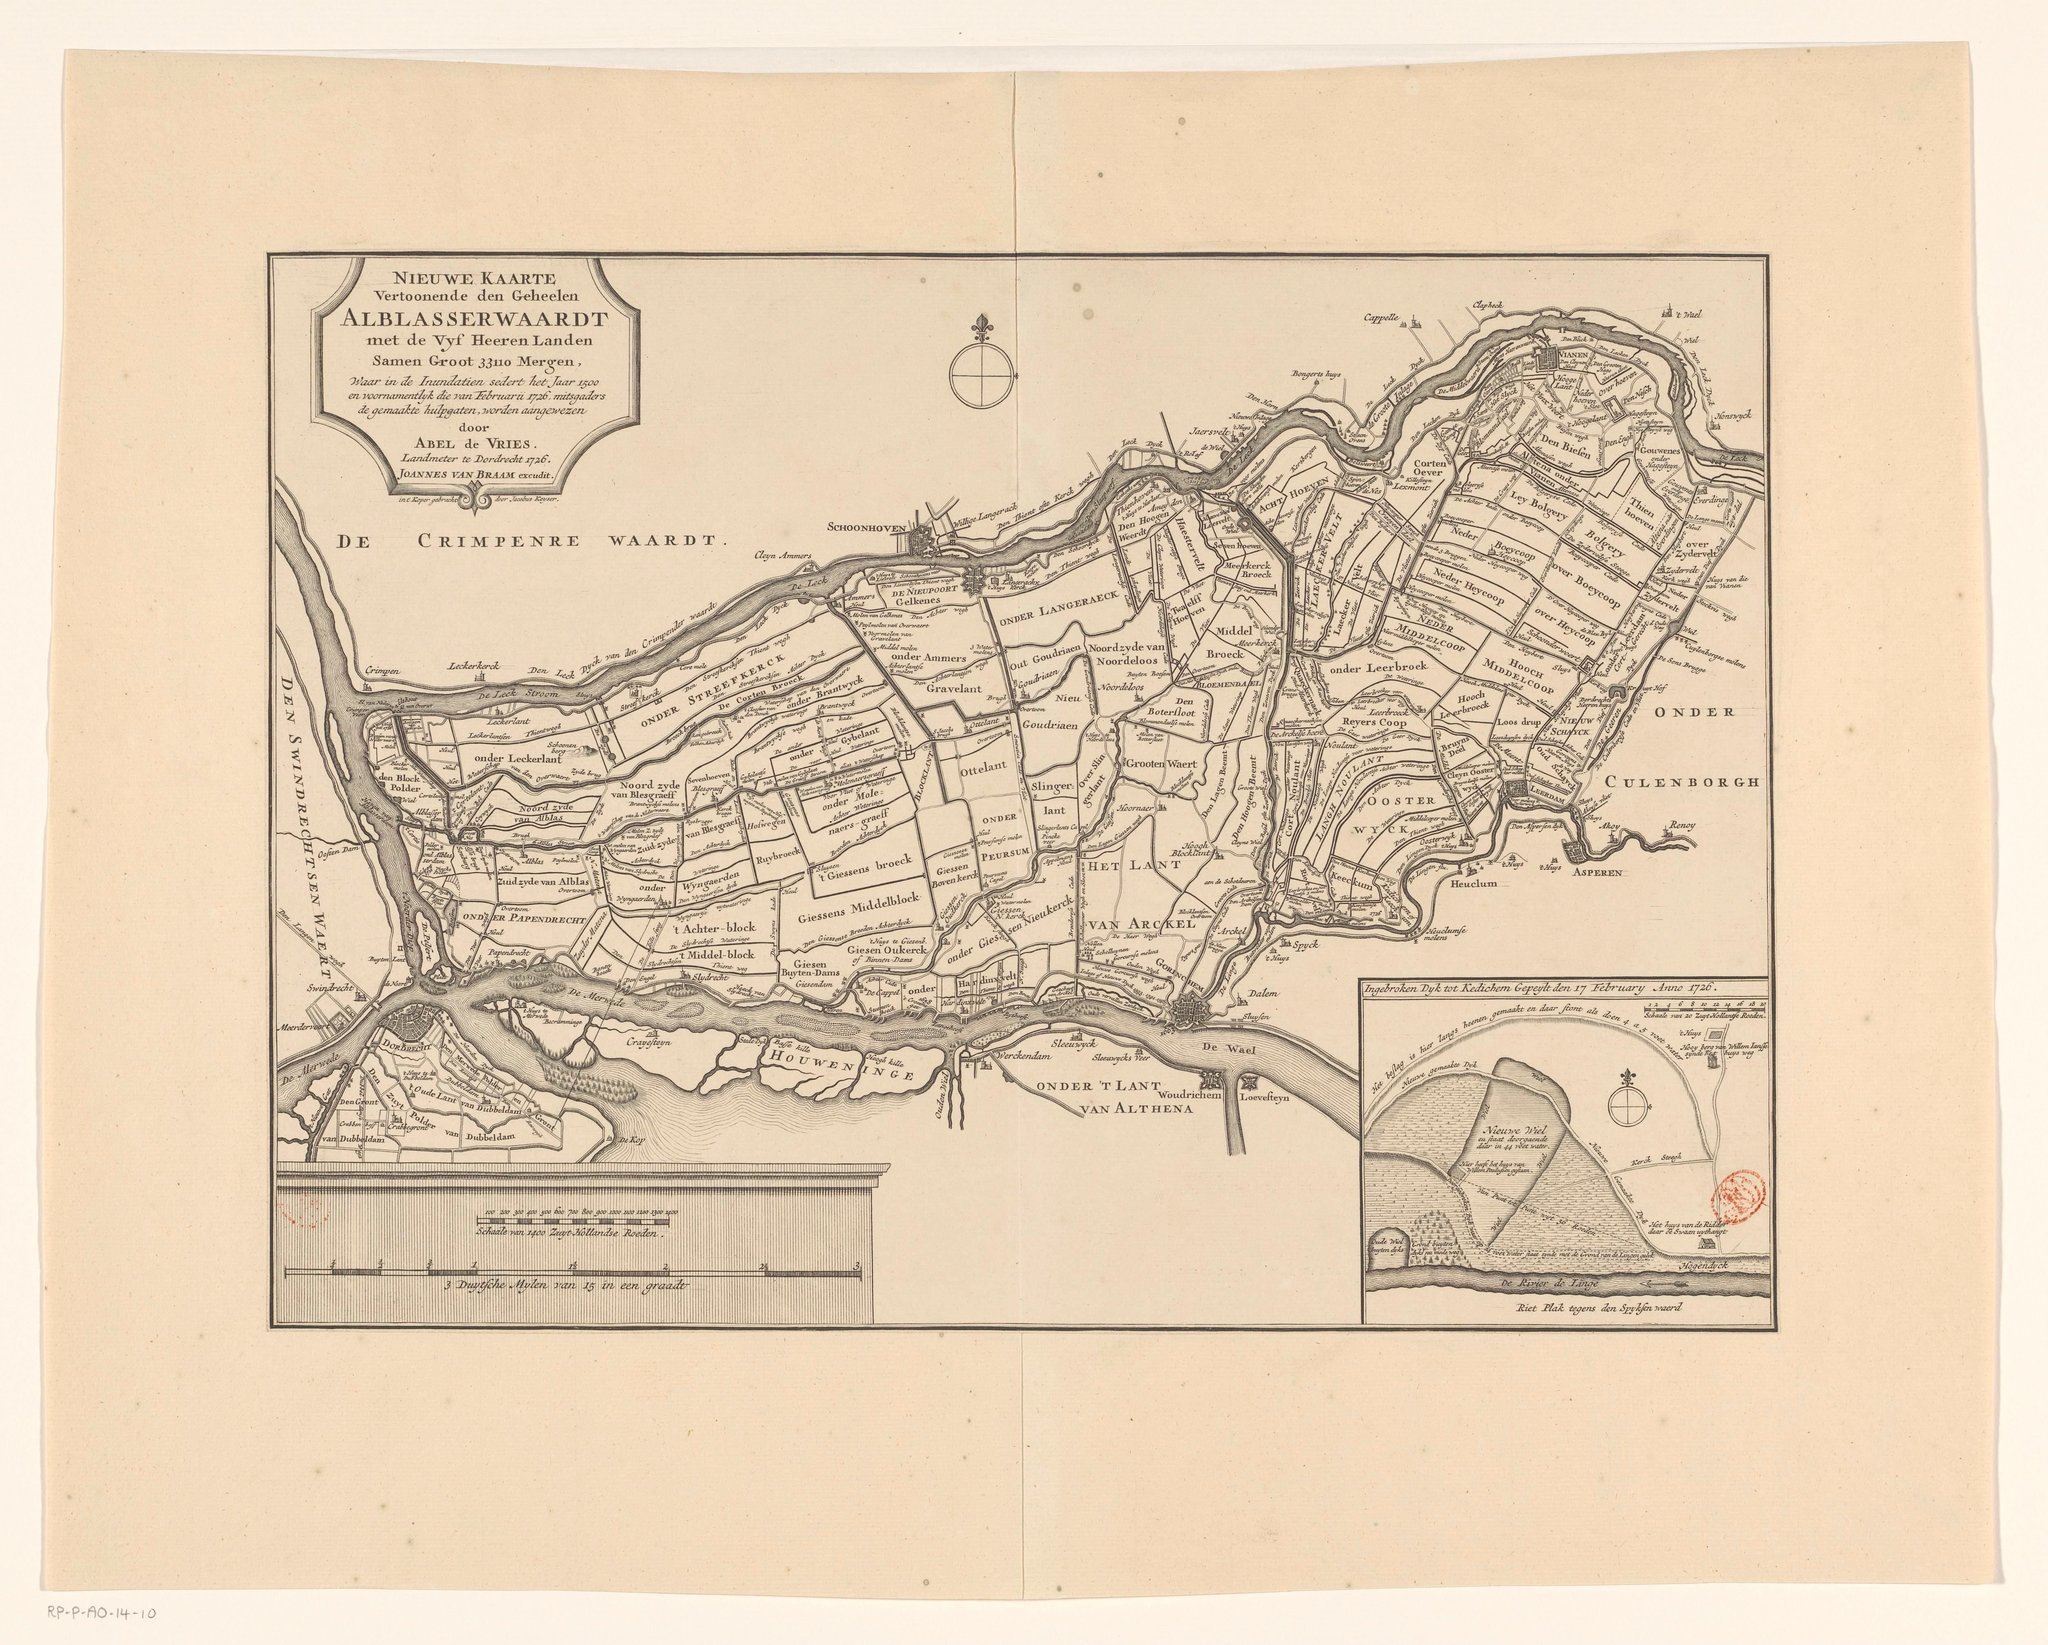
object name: print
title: Nieuwe kaarte vertoonende den geheelen Alblasserwaardt met de Vyf Heeren Landen samen groot 33110 mergen, waar in de inundatien sedert het jaar 1500 en voornamentlyk die van februarii 1726, mitsgaders de gemaakte hulpgaten, worden aangewezen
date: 1726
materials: paper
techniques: engraving, etching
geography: dordrecht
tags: maps of separate countries or regions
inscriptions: collector's mark: Lugt 195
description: Kaart van de Alblasserwaard en de Vijfheerenlanden, waarop overstromingen sinds 1500 staan aangegeven. Linksboven de titelcartouche. Linksonder een cartouche met twee schaalstokken: Schaale van 1400 Zuyt-Hollandse roeden; 3 Duytsche mylen van 15 in een graadt. Rechtsonder een inzetkaart met de doorbraak van de dijk bij Kedichem in 1726. Rechtsboven op de inzetkaart een schaalstok: Schaale van 20 Zuyt Hollantse roeden.